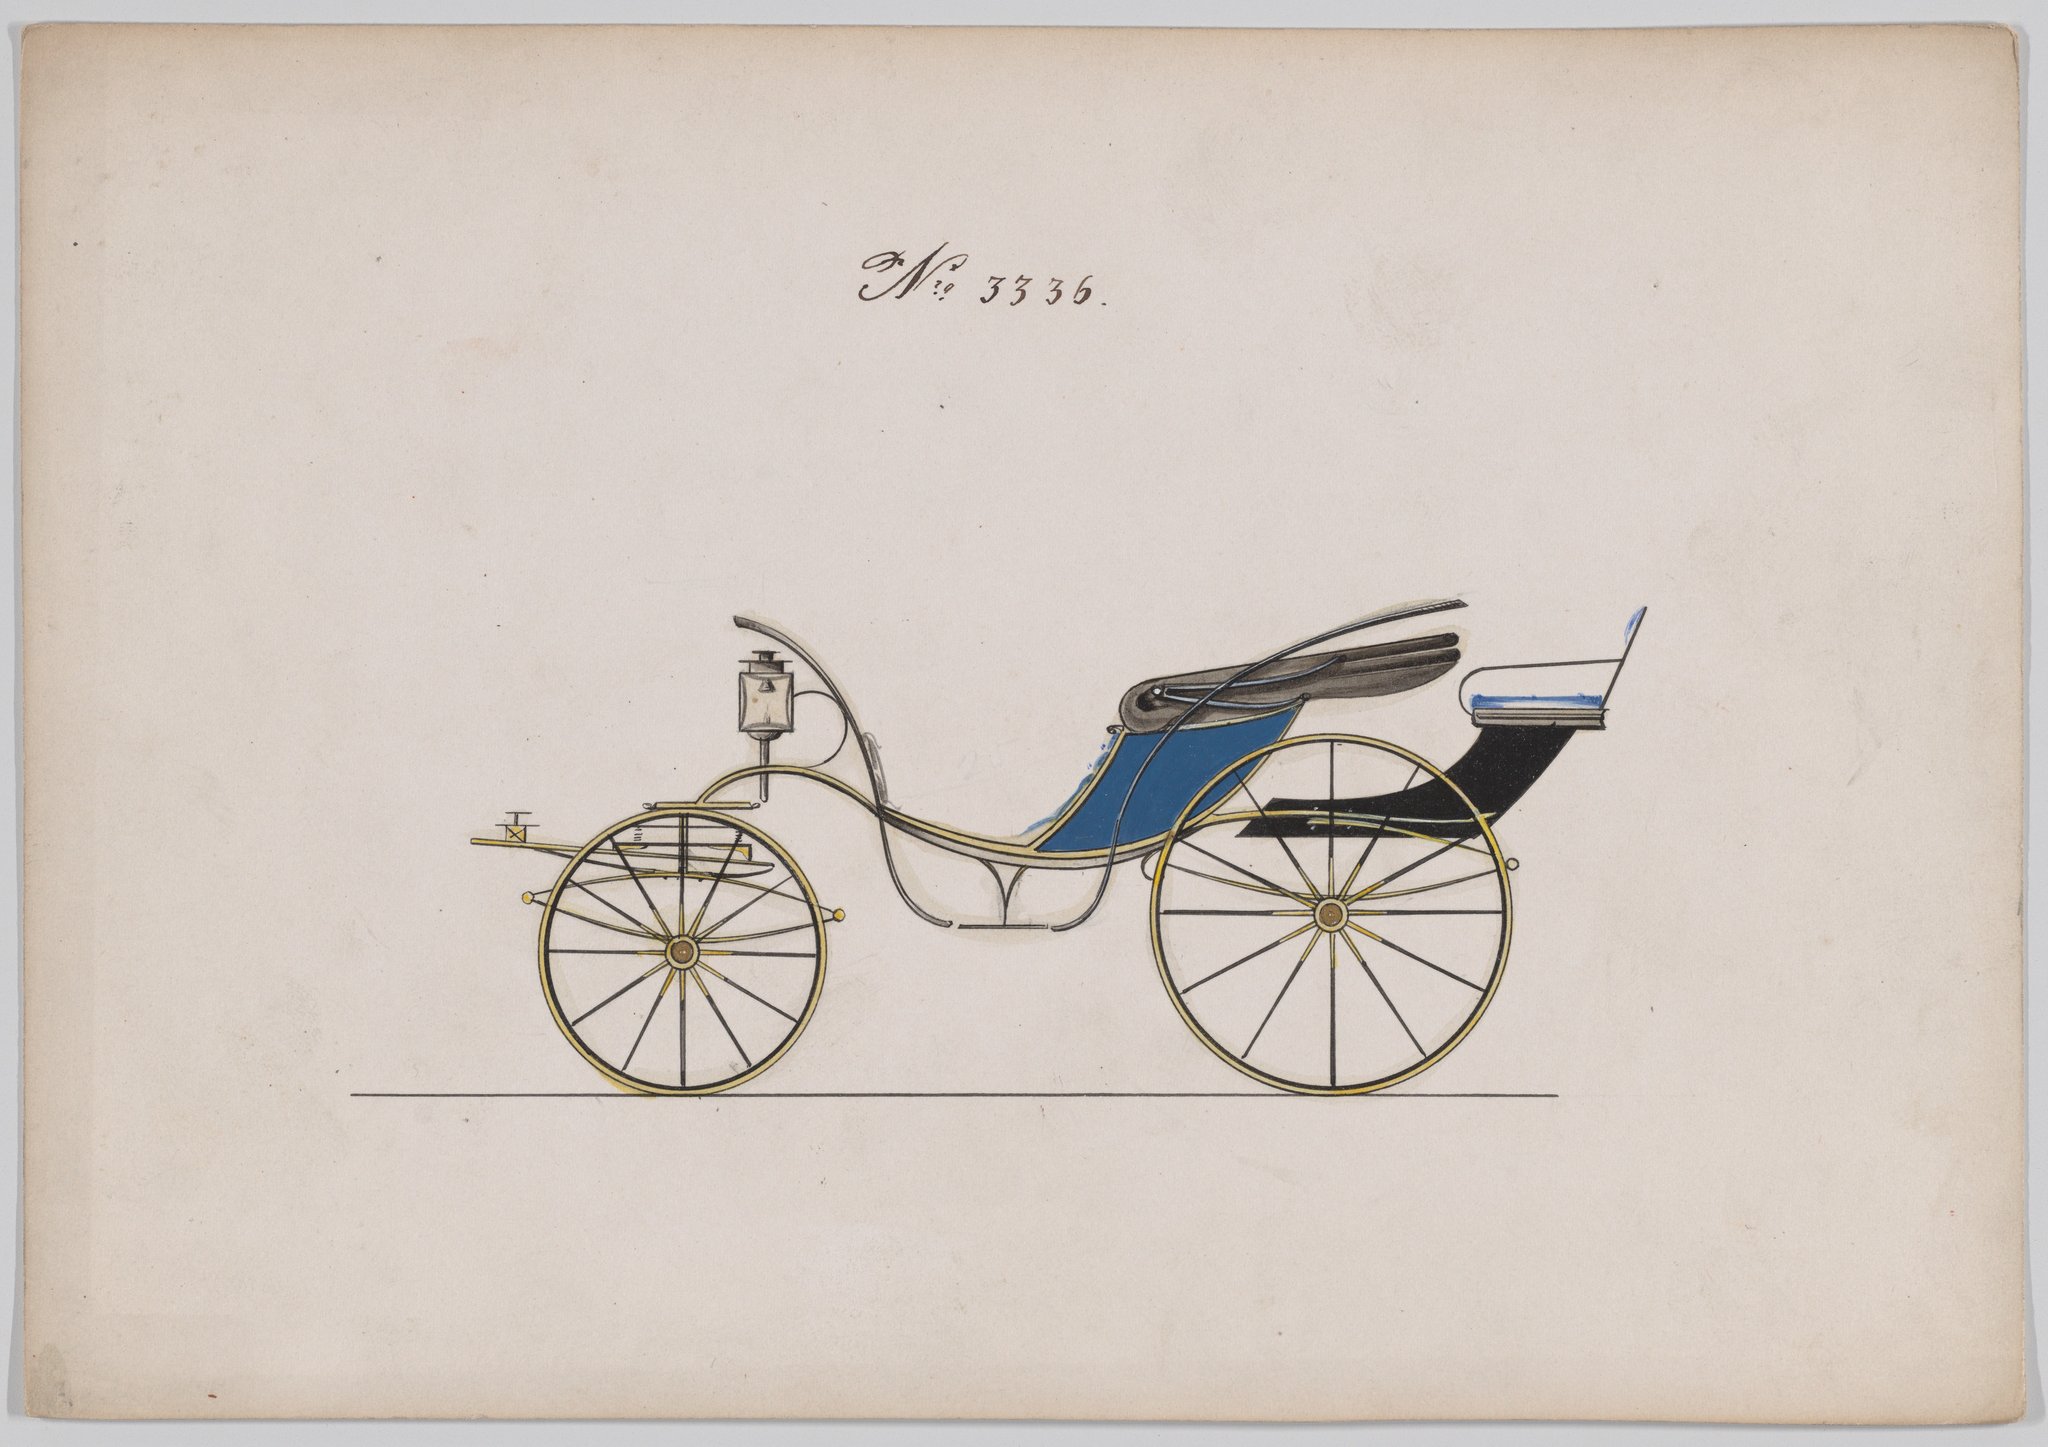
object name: drawing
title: Design for Pony Phaeton, no. 3336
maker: brewster & co.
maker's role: manufacturer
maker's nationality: american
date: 1877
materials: gouache, gum arabic, ink, watercolor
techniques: pen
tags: carriages